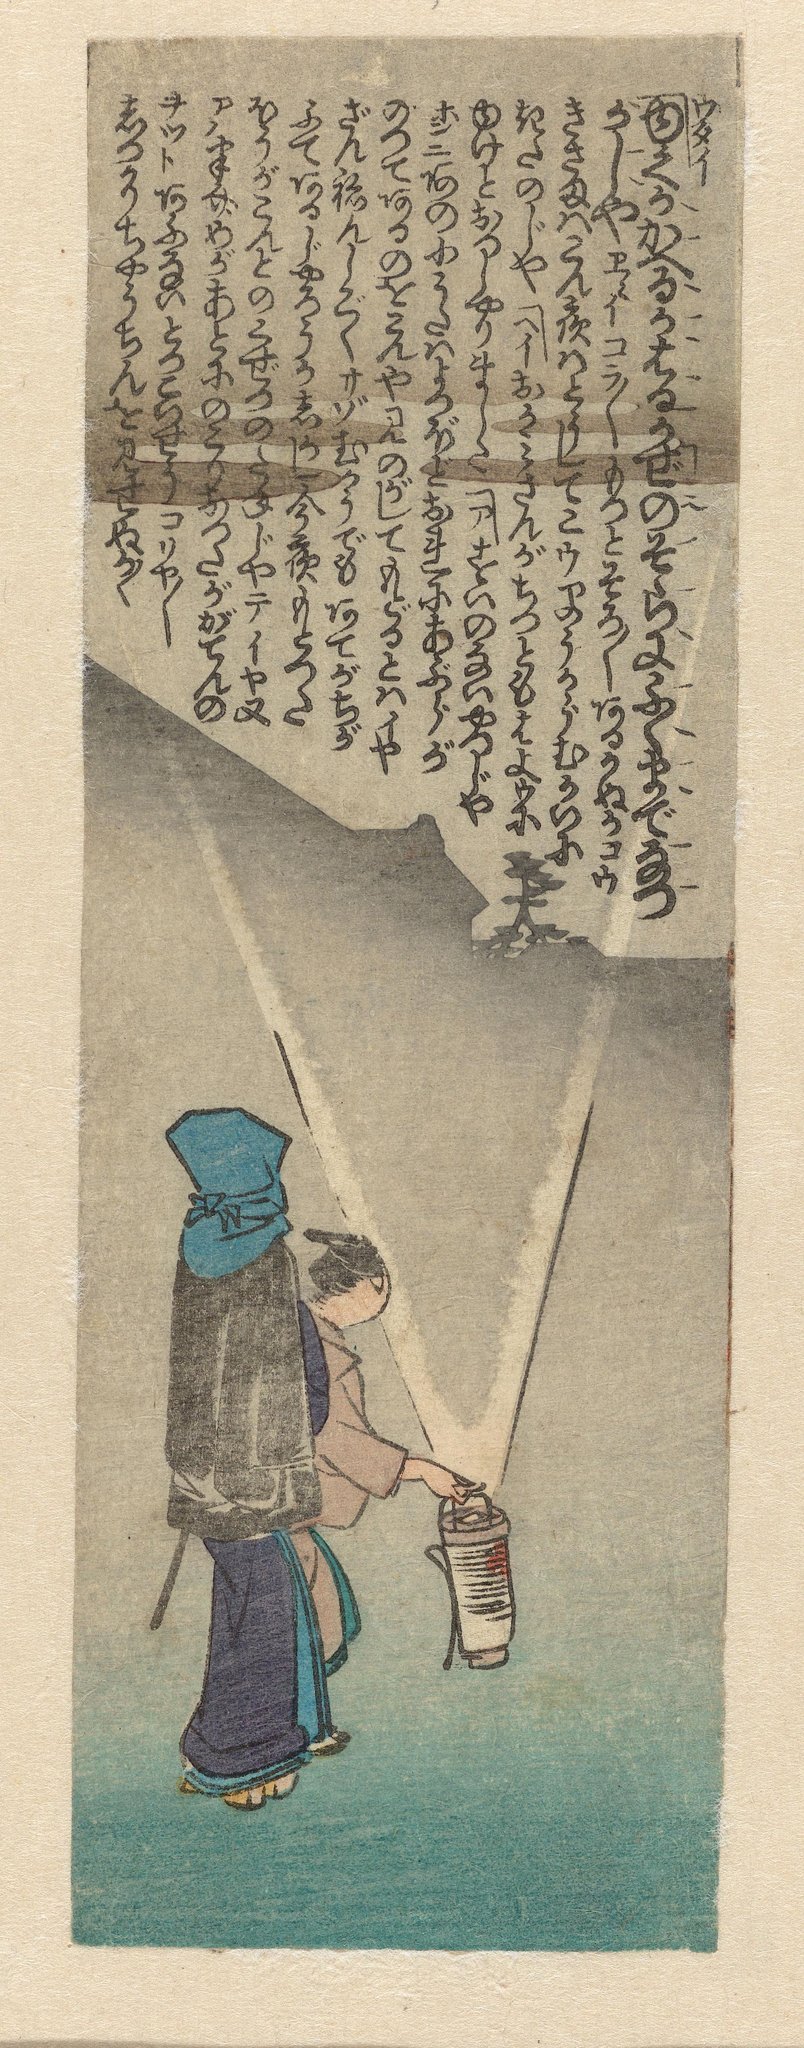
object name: print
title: Bepakte man met lampion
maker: Anonymous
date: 1850-1860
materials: paper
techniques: woodcut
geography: japan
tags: lantern